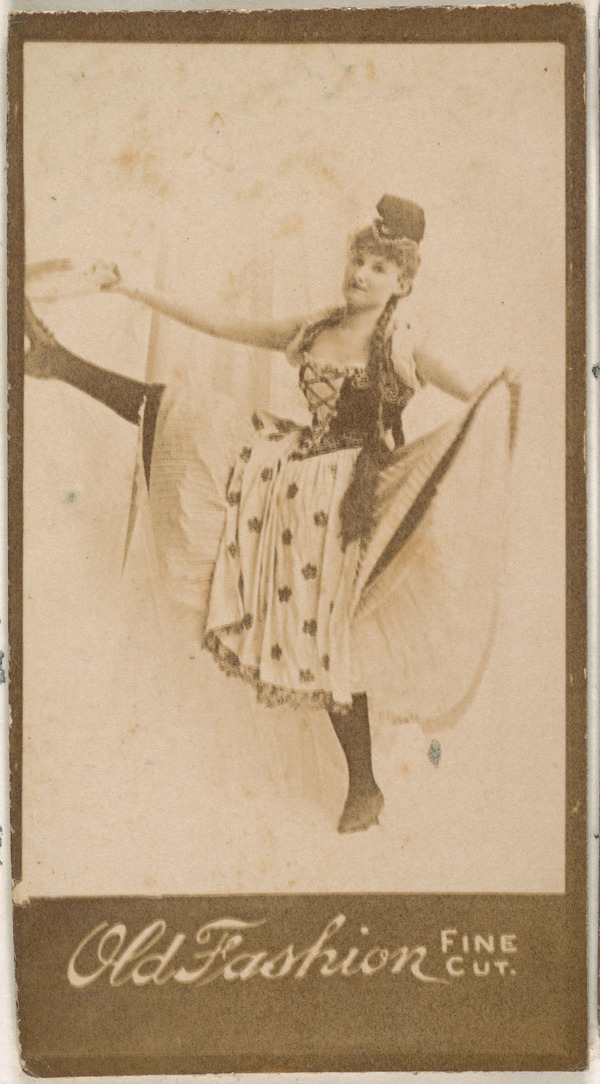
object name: photograph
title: Dancer, from the Actresses series (N664) promoting Old Fashion Fine Cut Tobacco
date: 1888-1890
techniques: albumen silver print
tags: portraits,women,actresses,dancers